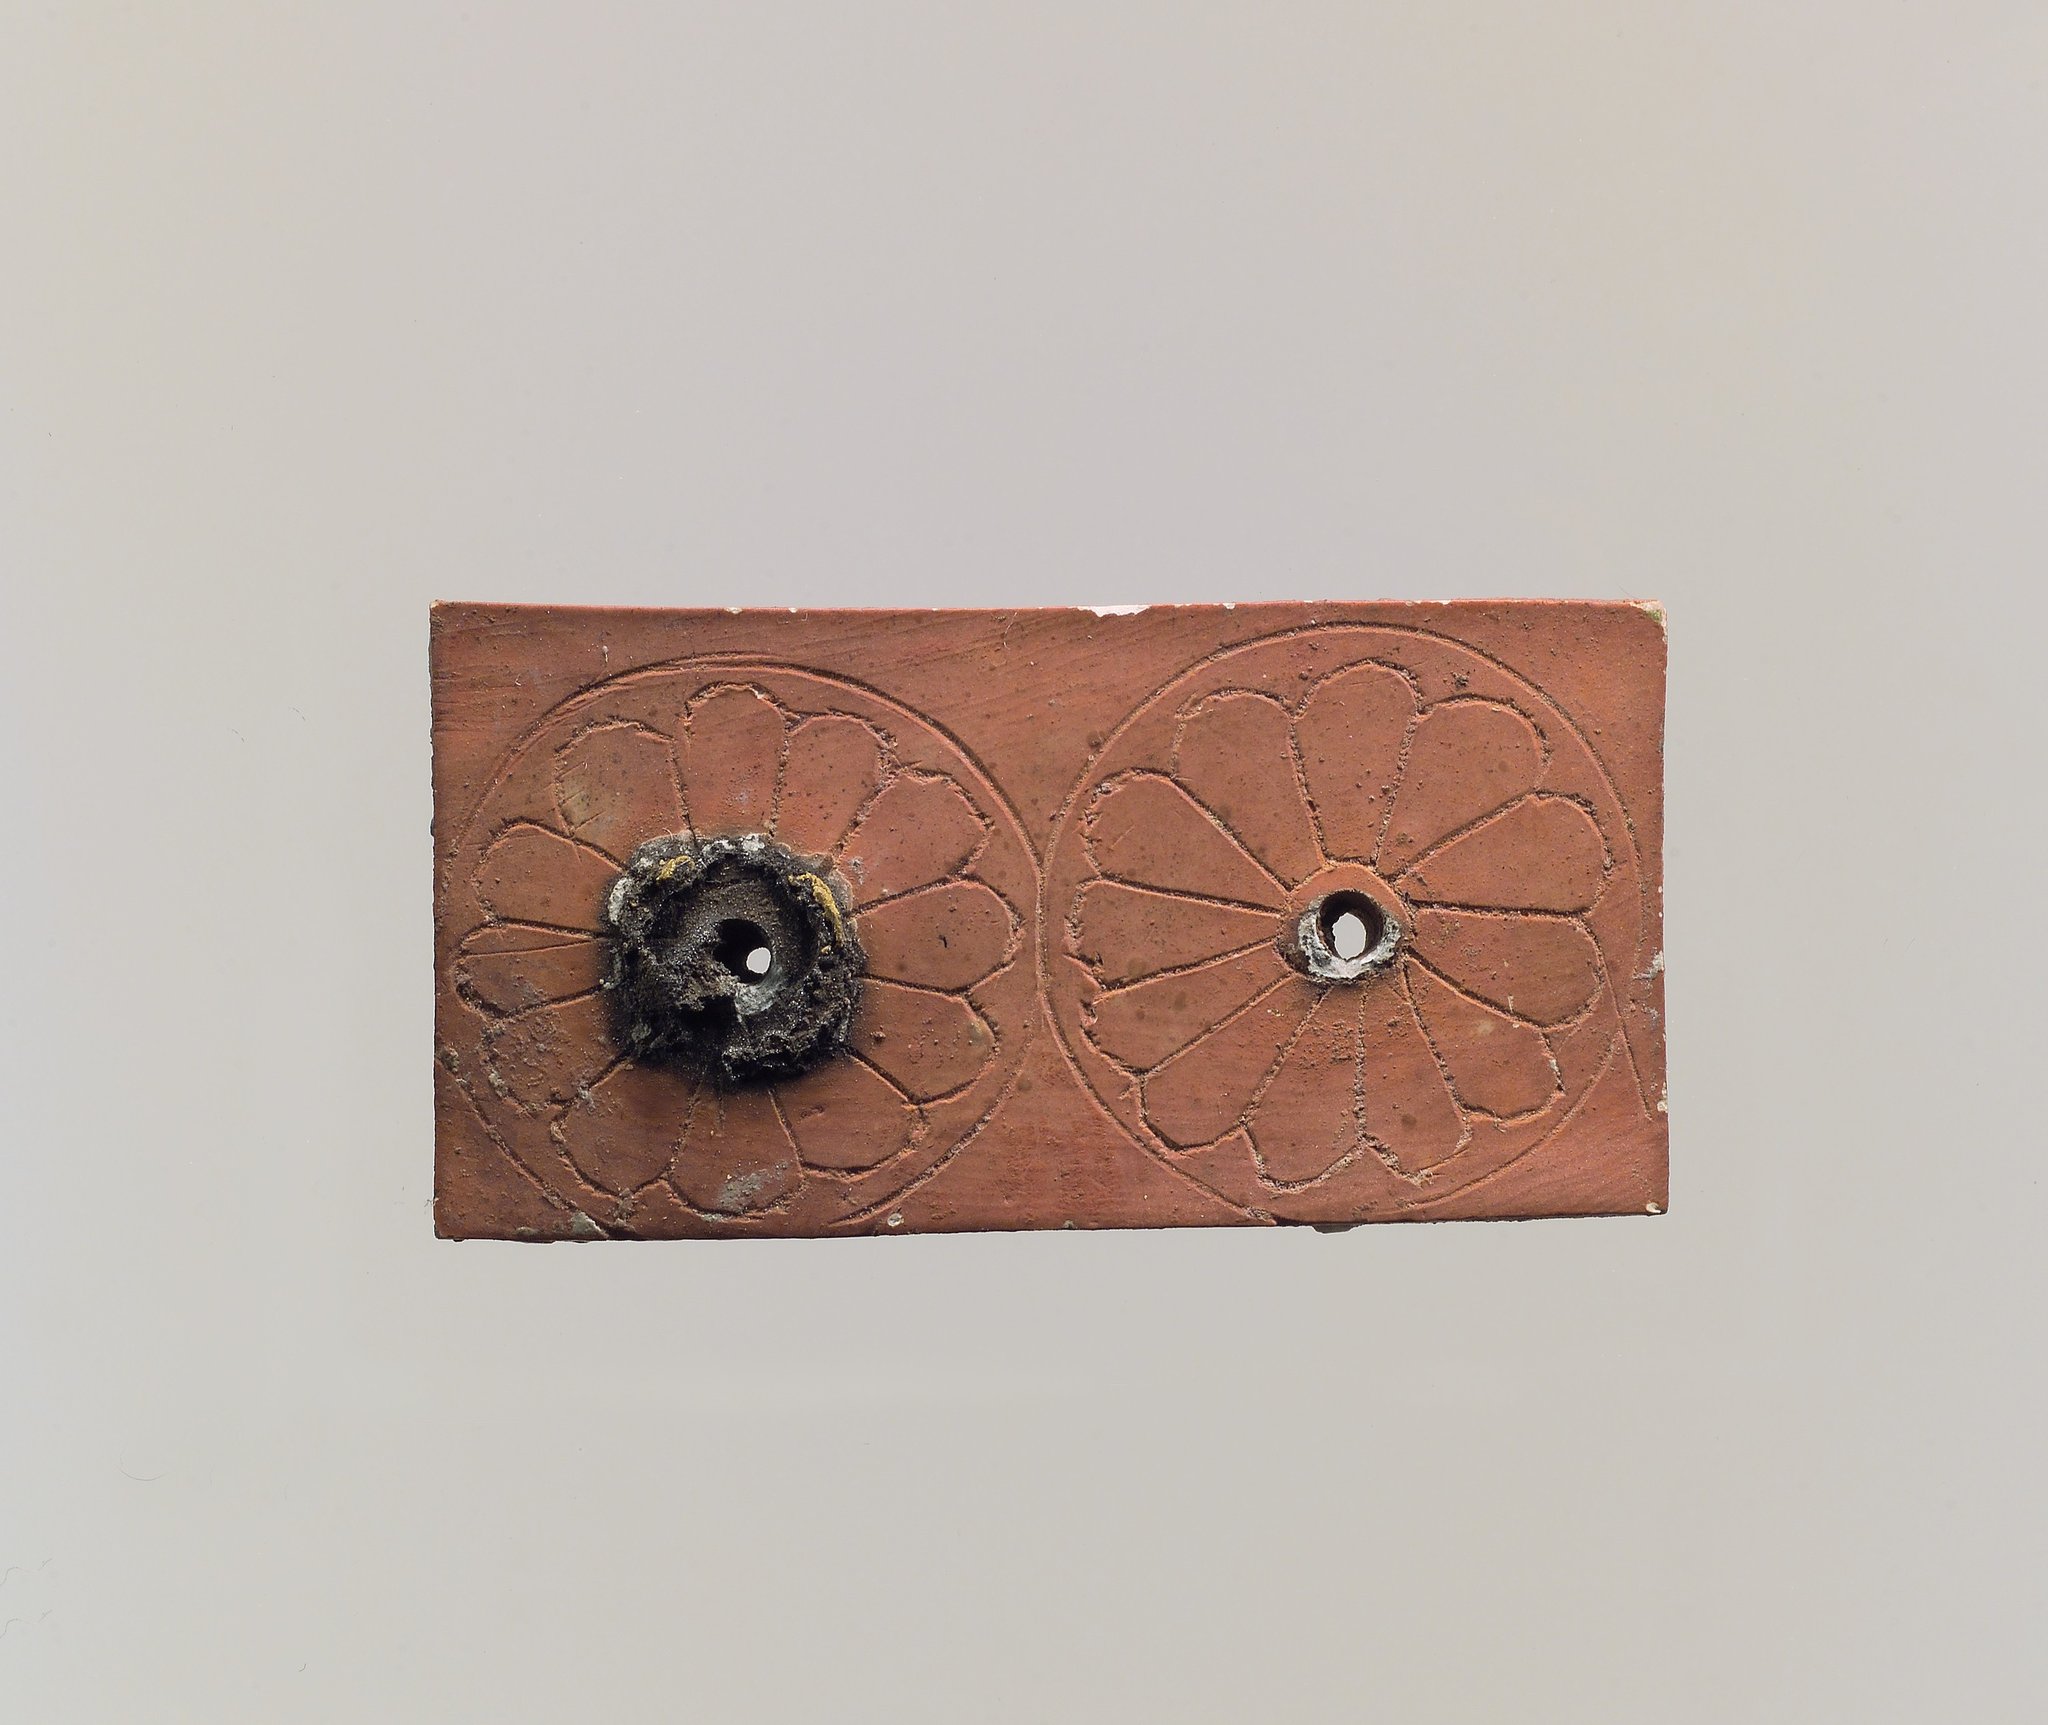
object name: relief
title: Plaque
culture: assyrian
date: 1800-1701 BCE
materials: ivory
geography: anatolia